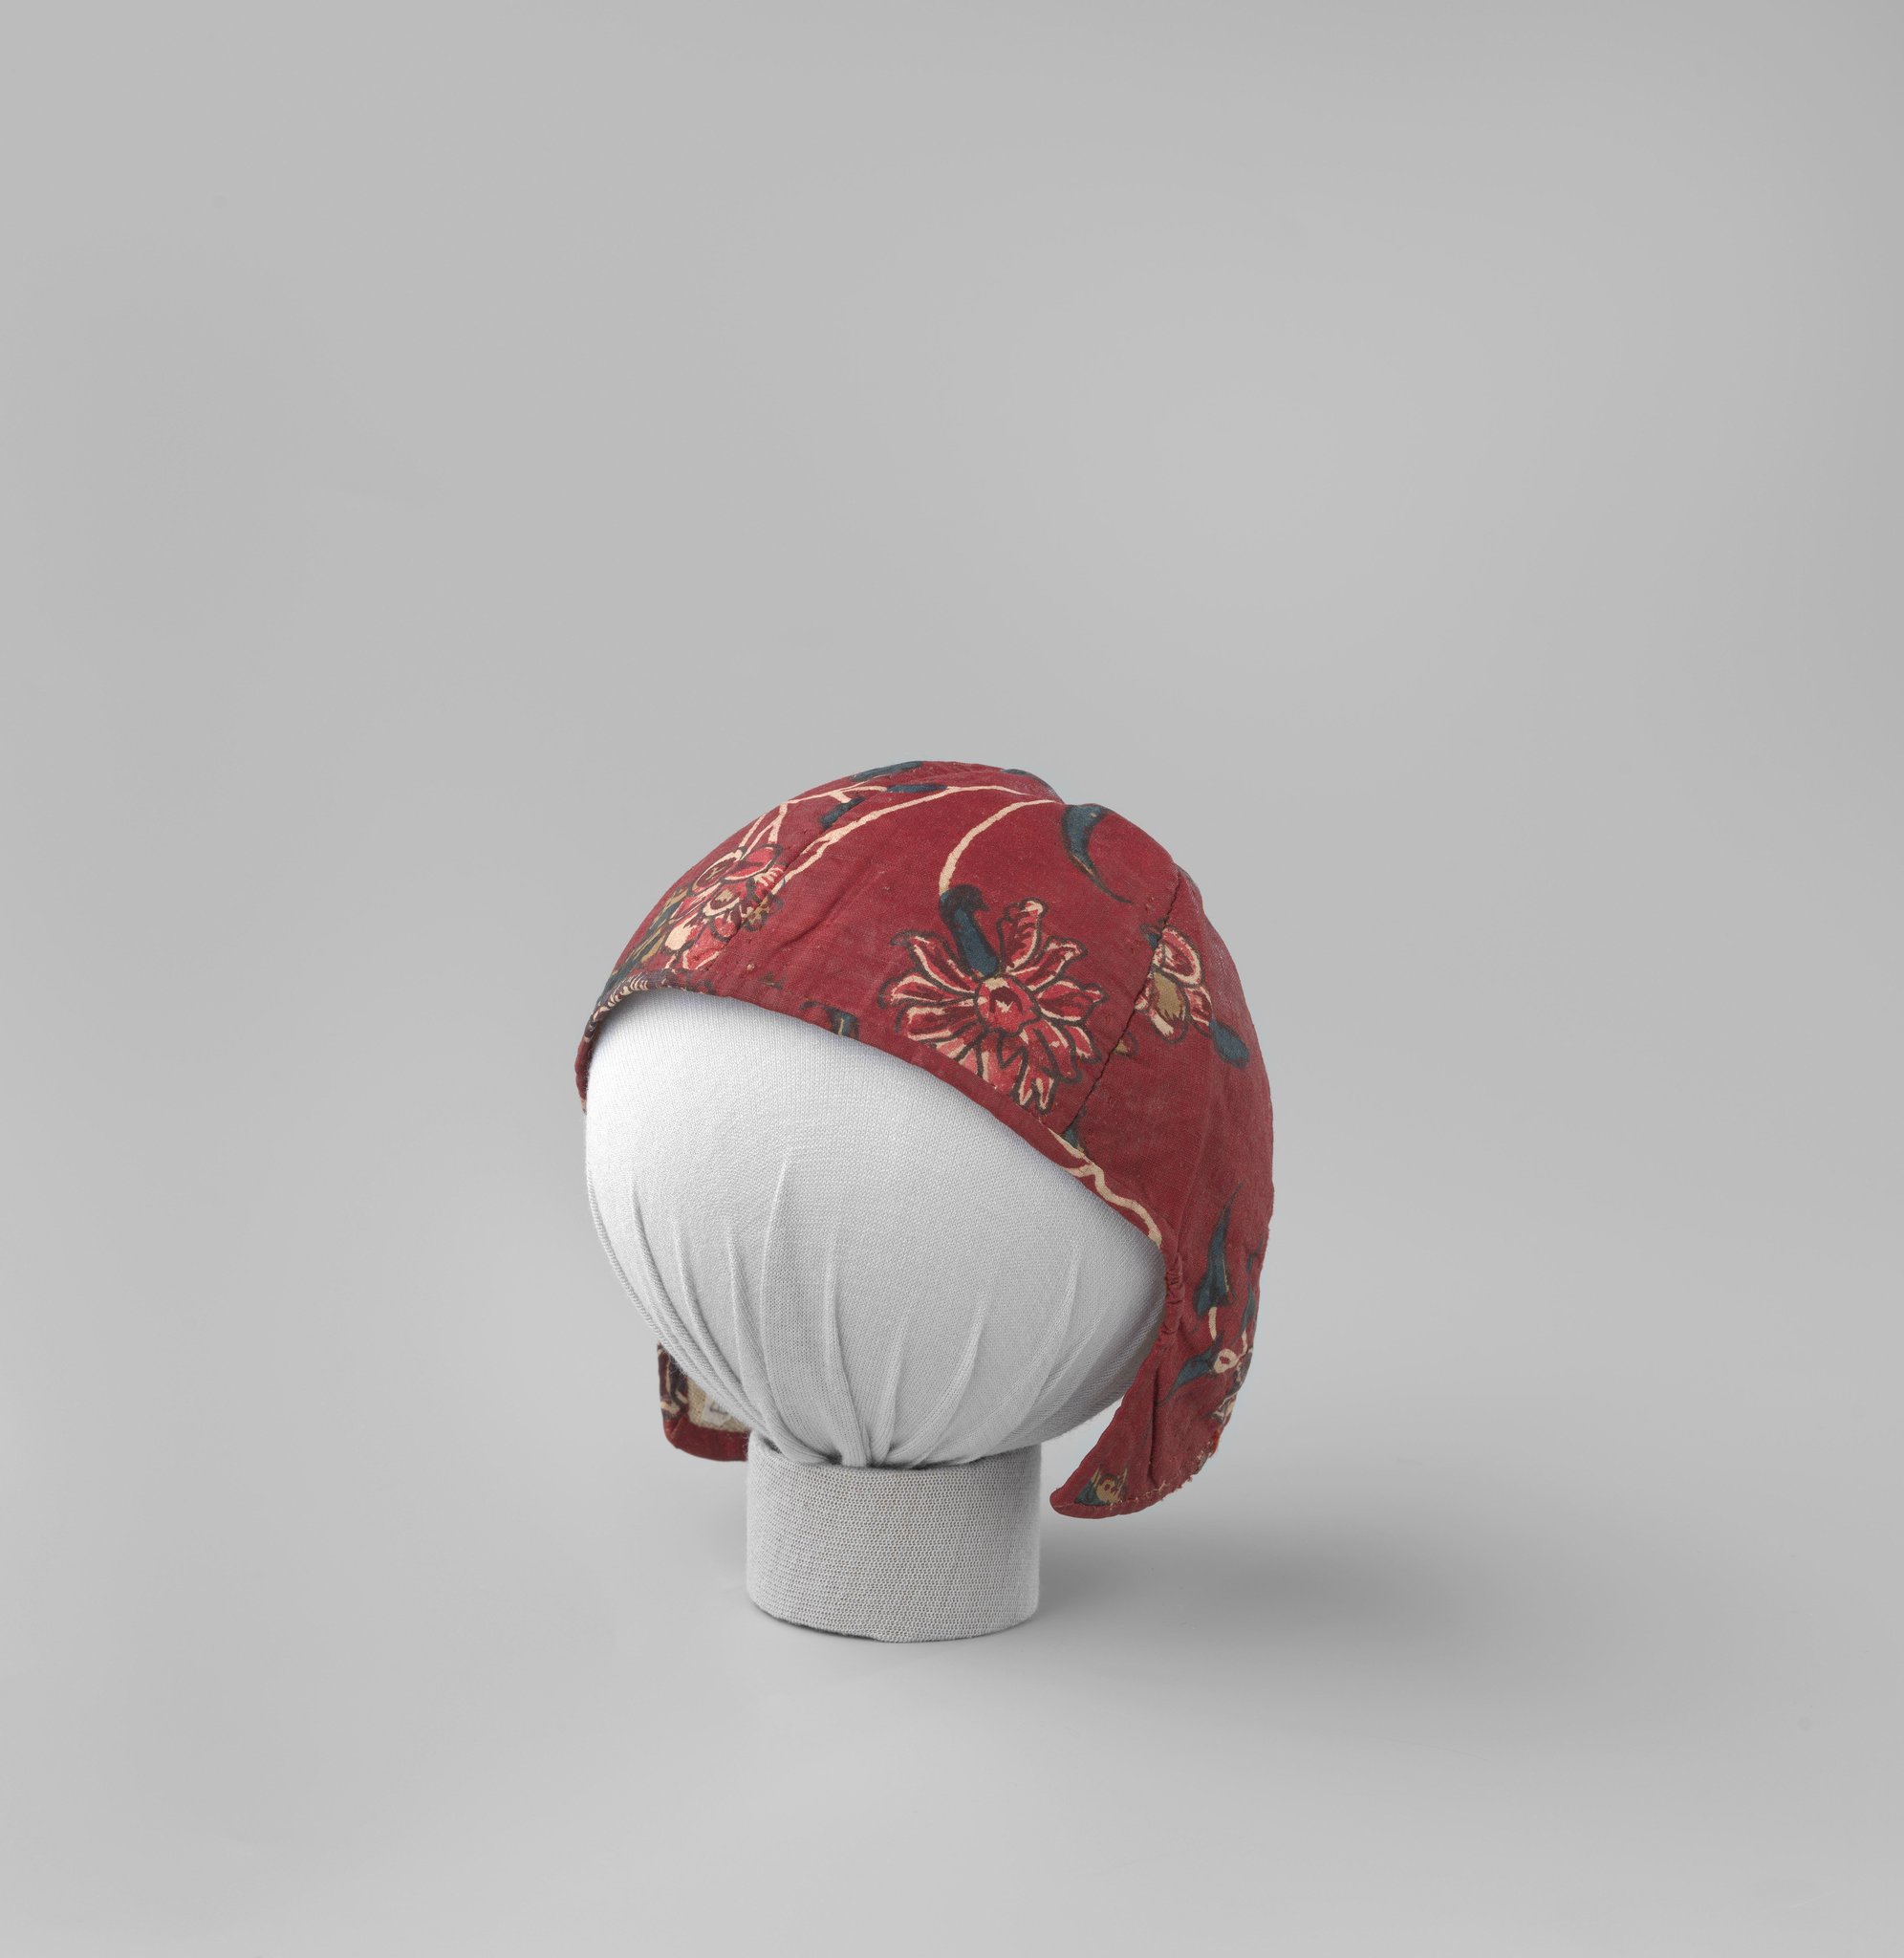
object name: cap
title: Kindermuts van sits dat op een rood fond donkergekleurde bloemmotieven met witte stelen vertoont; voering van wit linnen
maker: Anonymous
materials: textile, cotton, linen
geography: schiermonnikoog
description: Een muts, rood met gekleurde bloemen (deel van een Fries kinderkostuum). Afkomtig uit Schiemonnikoog.